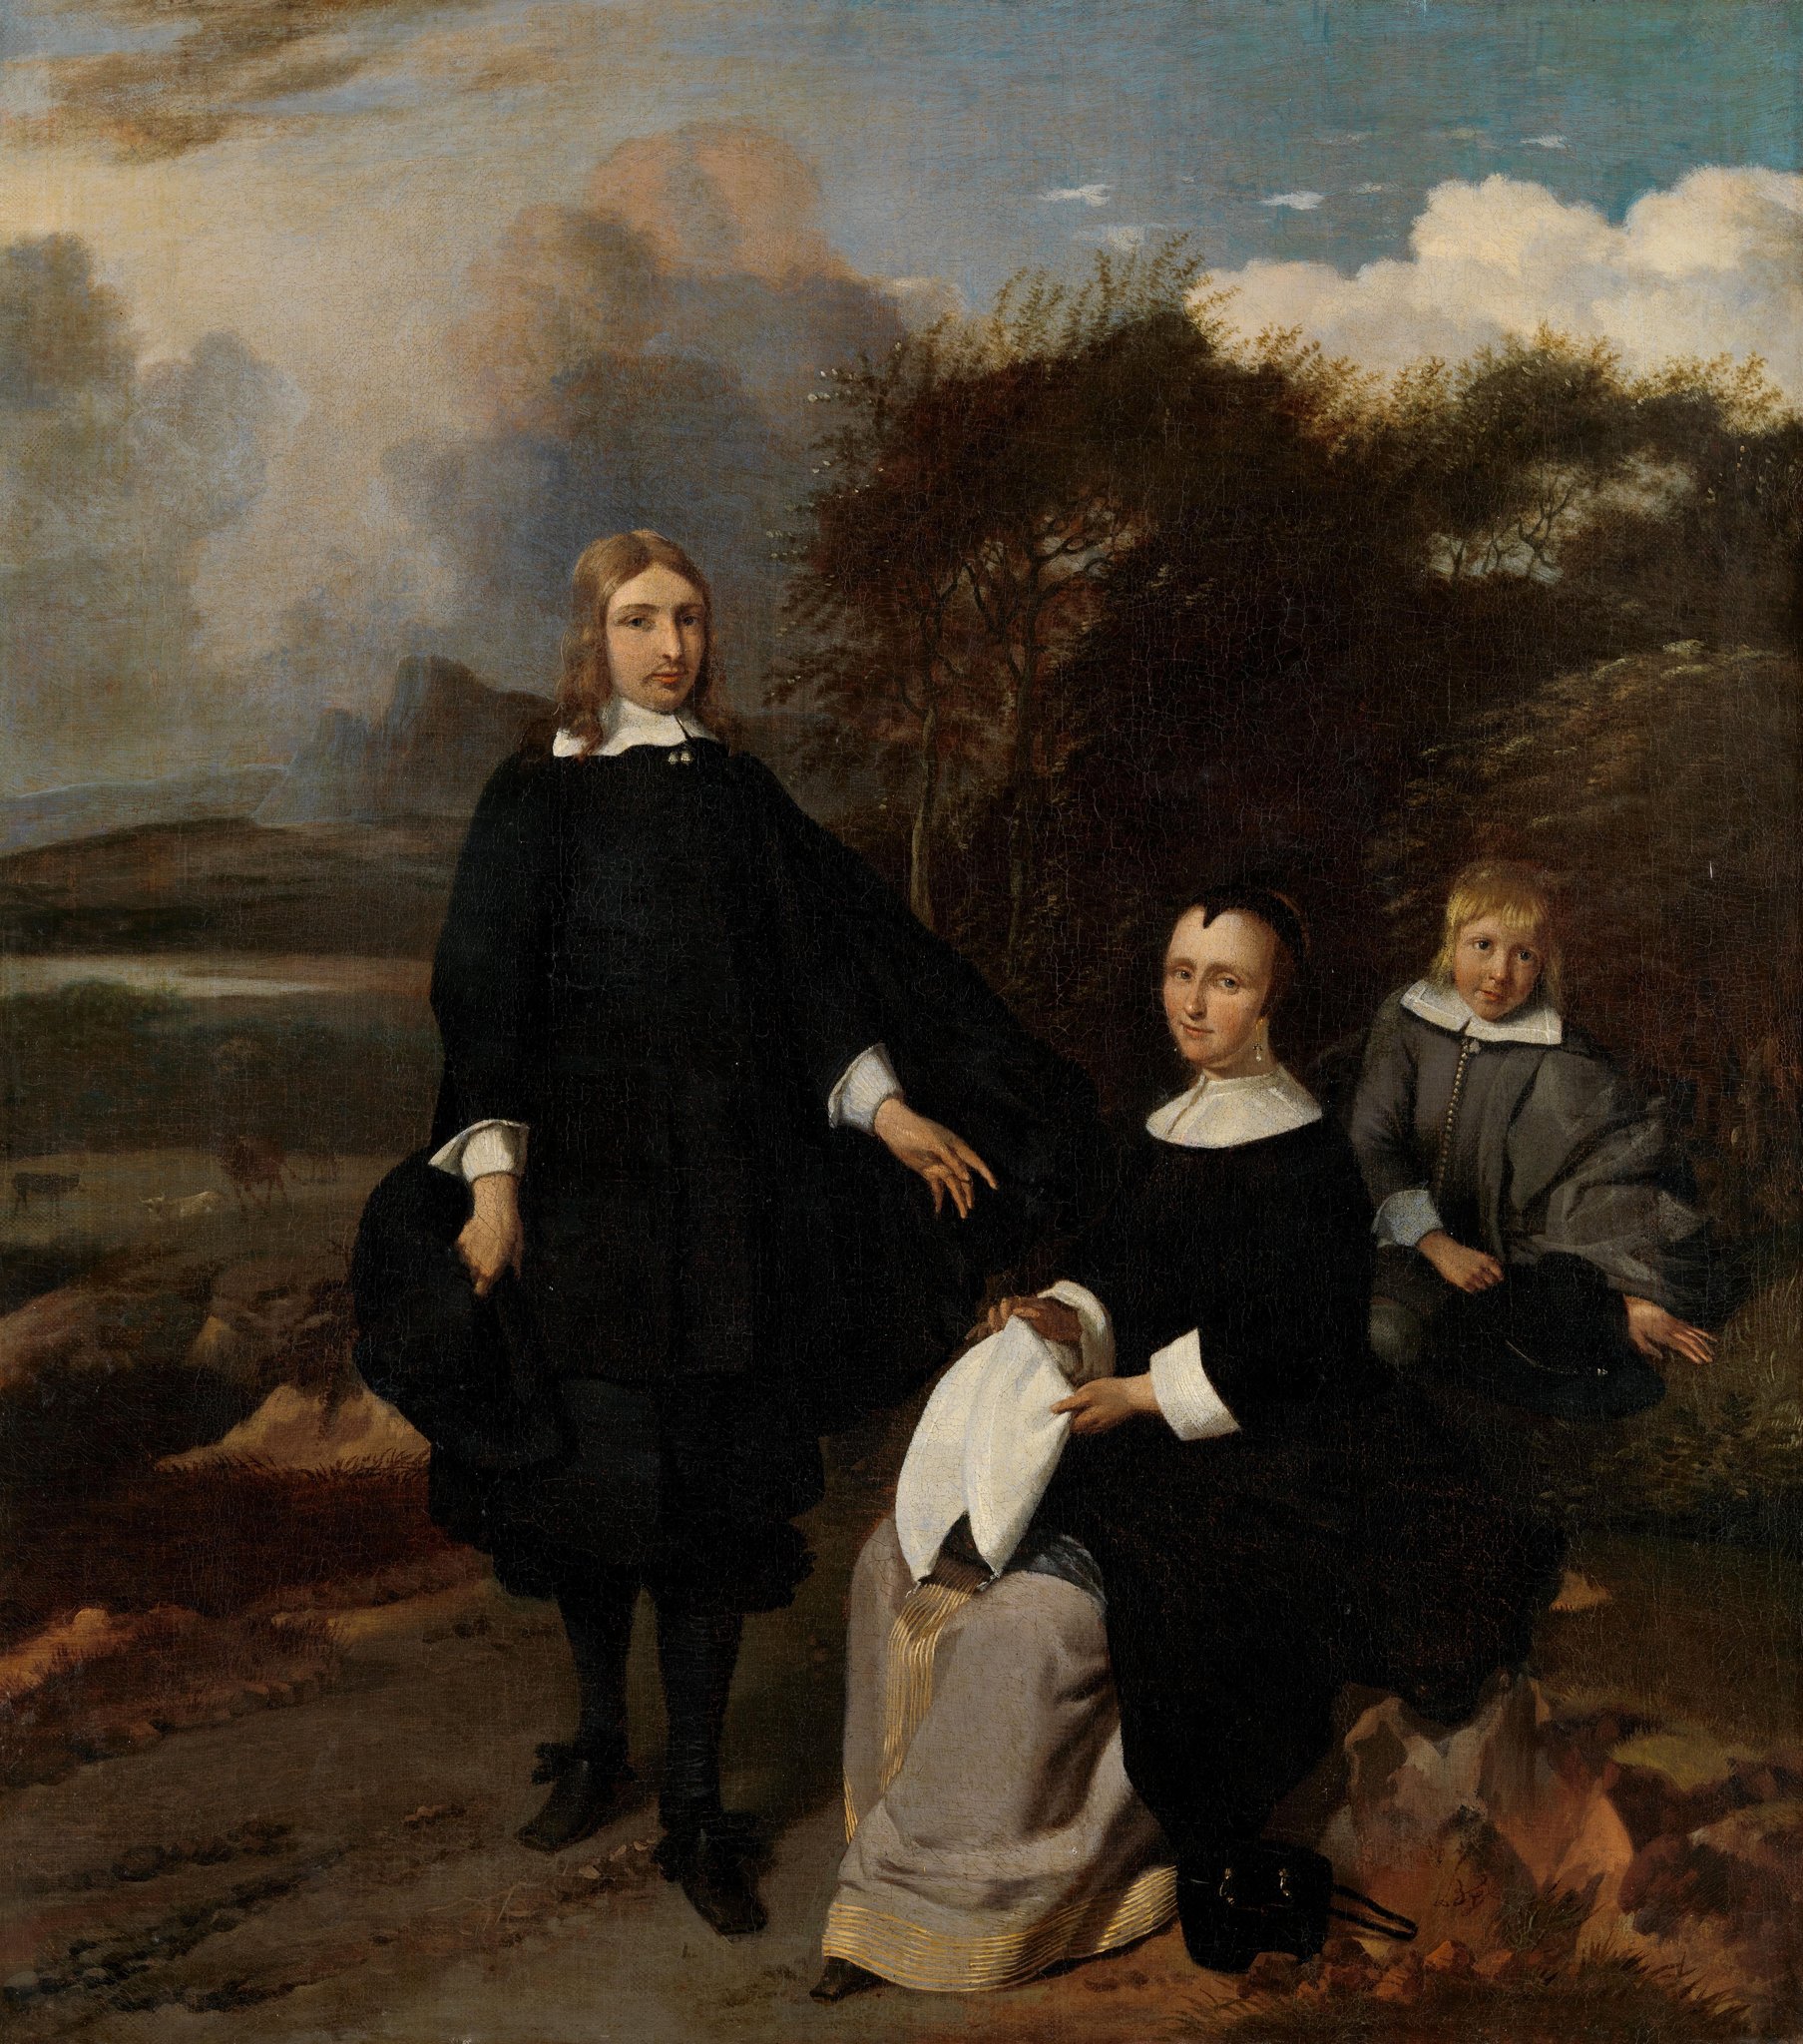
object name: painting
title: Family in a Landscape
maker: barend graat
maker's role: draughtsman, print maker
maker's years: 1628-1709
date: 1650-1660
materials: canvas, oil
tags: low hill country, family group, especially parents with their child(ren)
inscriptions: signature: ‘B.G. fe’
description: Familiegroep in een landschap. Een man staat links, rechts zitten de echtgenote en zoon. Links op de achtergrond een landschap met vee en bergen in de verte.